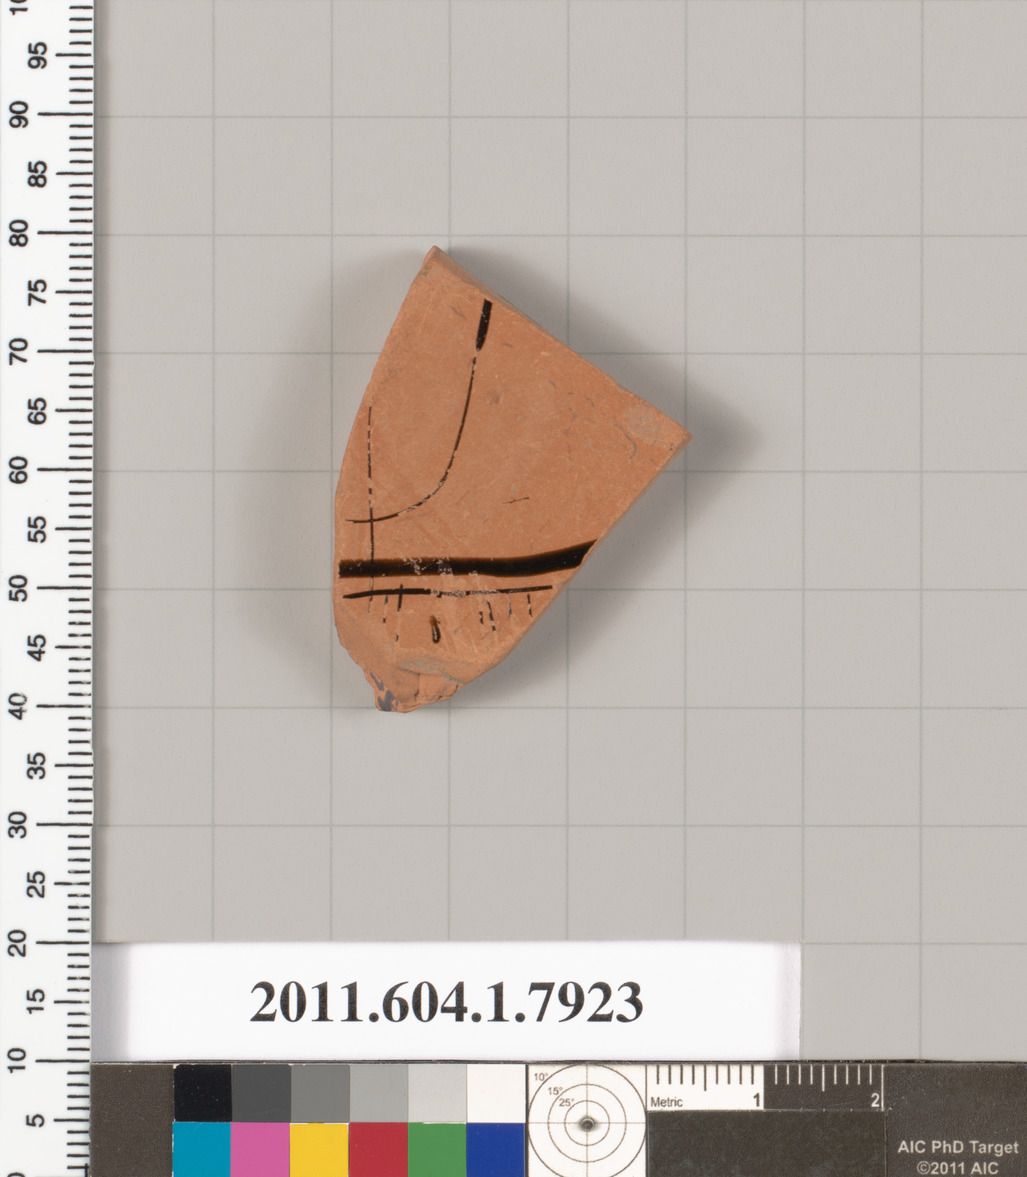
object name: kylix fragment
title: Terracotta fragment of a kylix (drinking cup)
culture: greek, attic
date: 460-450 BCE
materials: terracotta